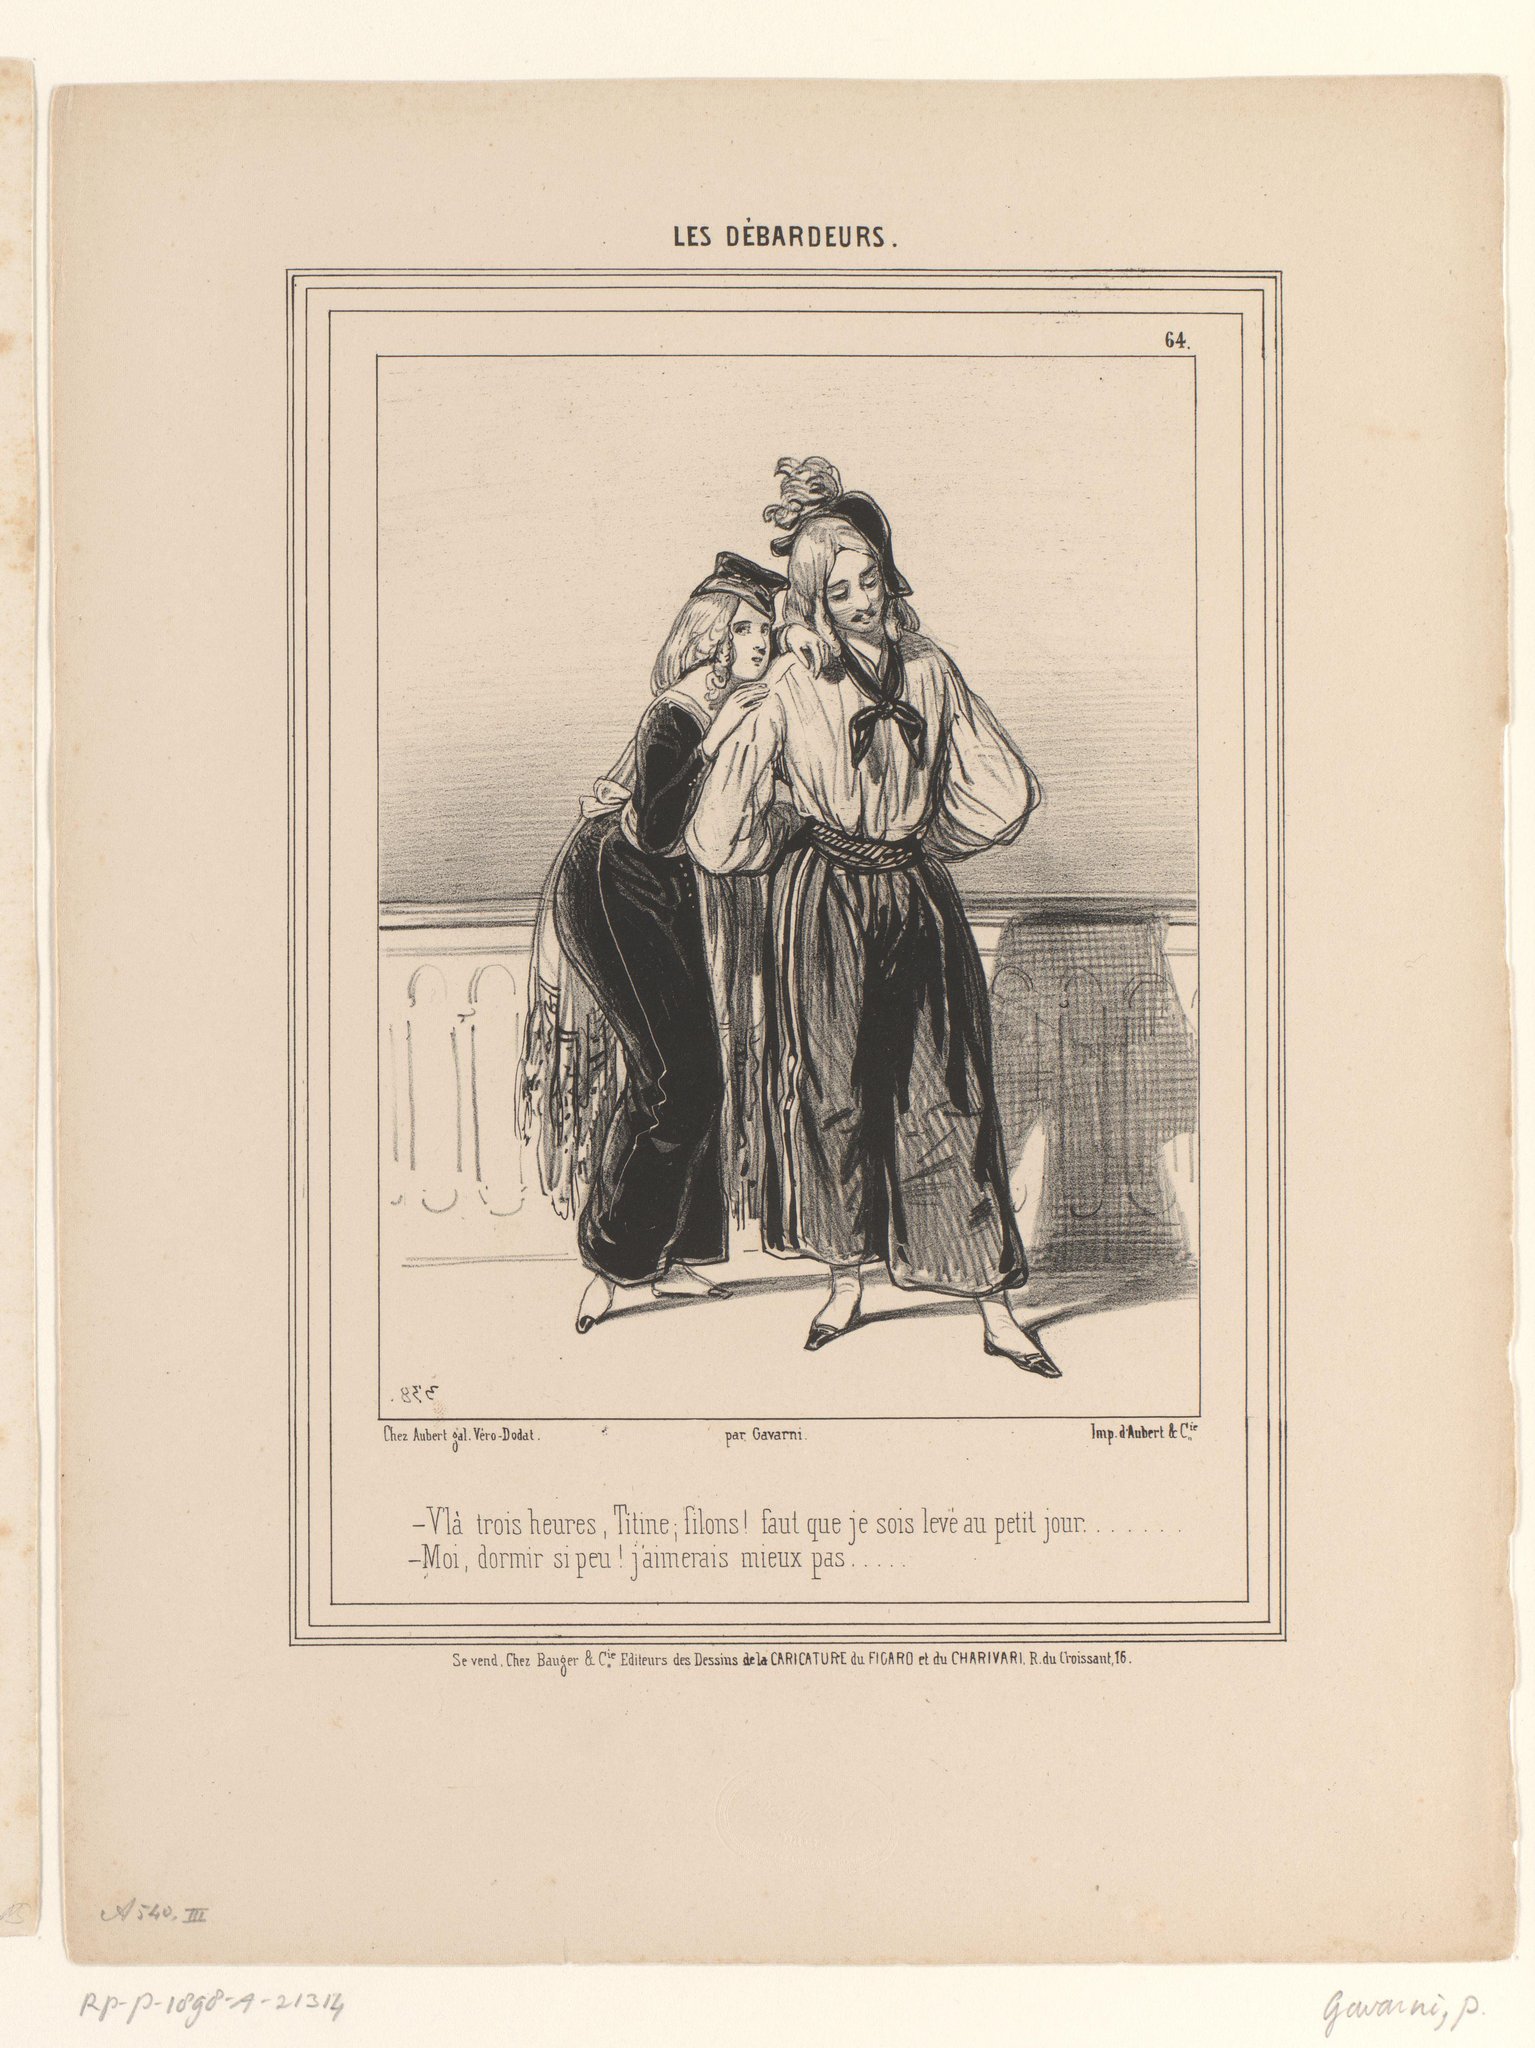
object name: cartoon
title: Liefdespaar in modieuze kostuums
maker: paul gavarni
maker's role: draughtsman, print maker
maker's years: 1804-1866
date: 1842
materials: paper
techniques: lithograph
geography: paris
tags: fashion, clothing, couple of lovers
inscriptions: collector's mark: Lugt 964, check stamp: Lugt 3855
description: Prent gebruikt voor: Le Charivari, 16 januari 1842.